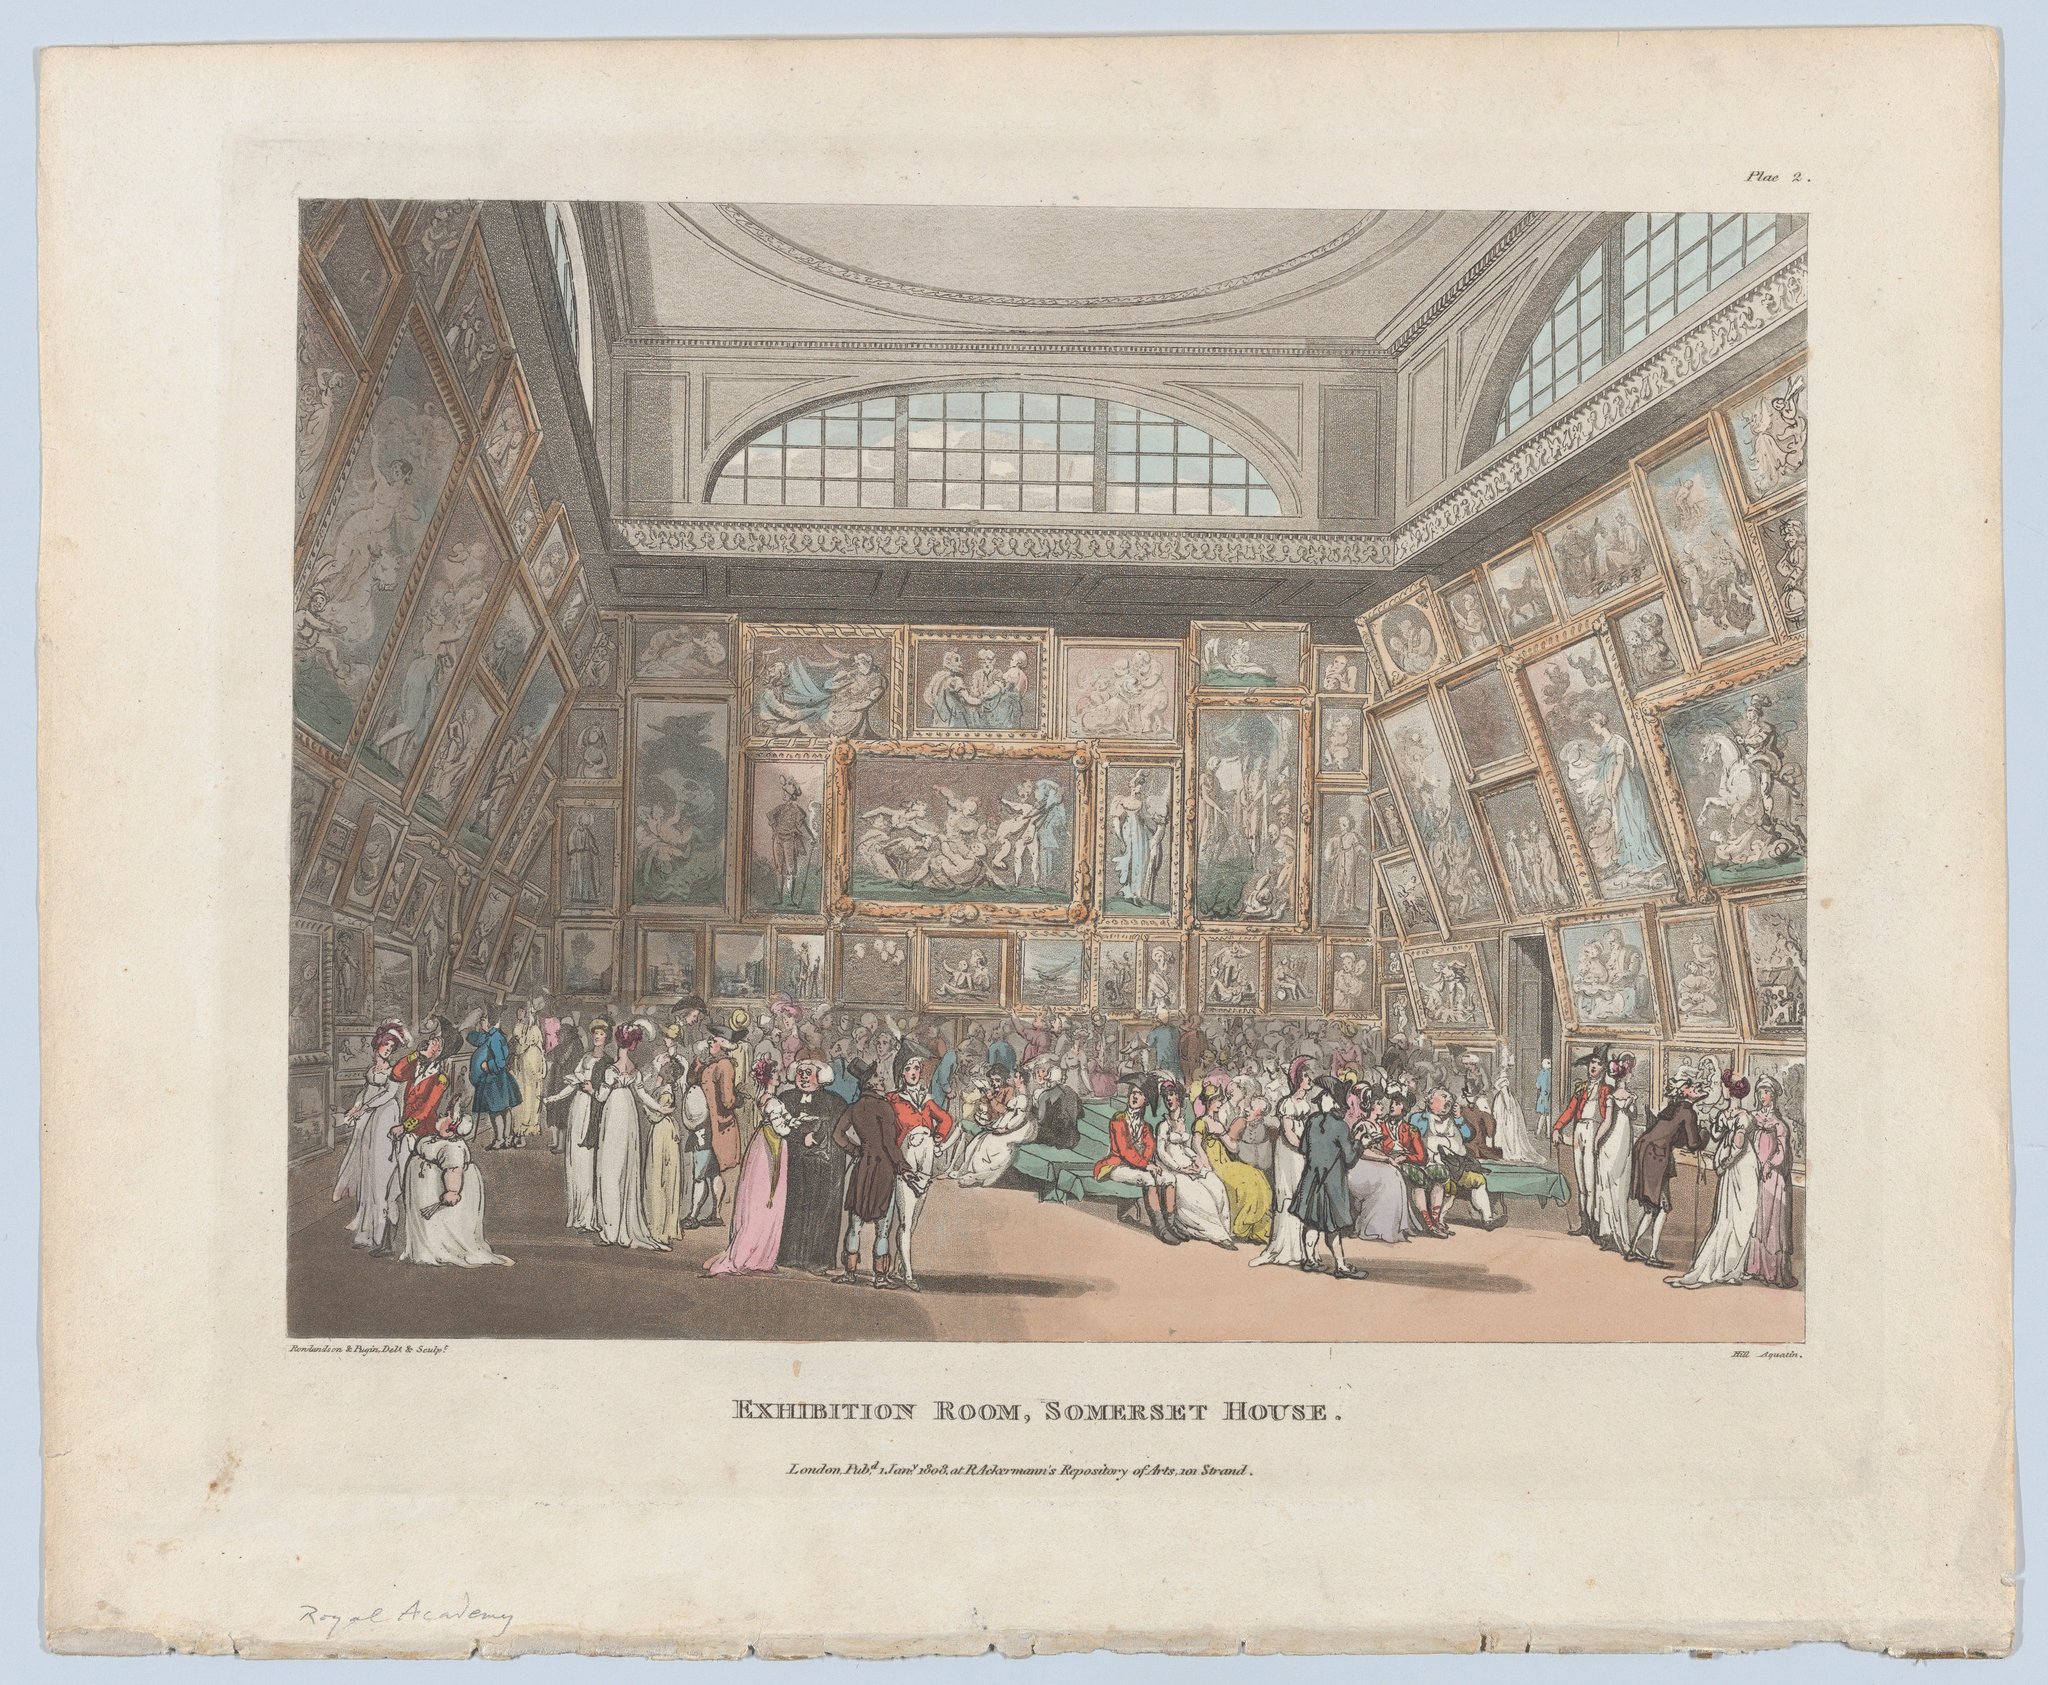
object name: print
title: Exhibition Room, Somerset House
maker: thomas rowlandson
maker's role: artist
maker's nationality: british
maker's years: 1757-1827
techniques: aquatint, etching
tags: interiors,crowd